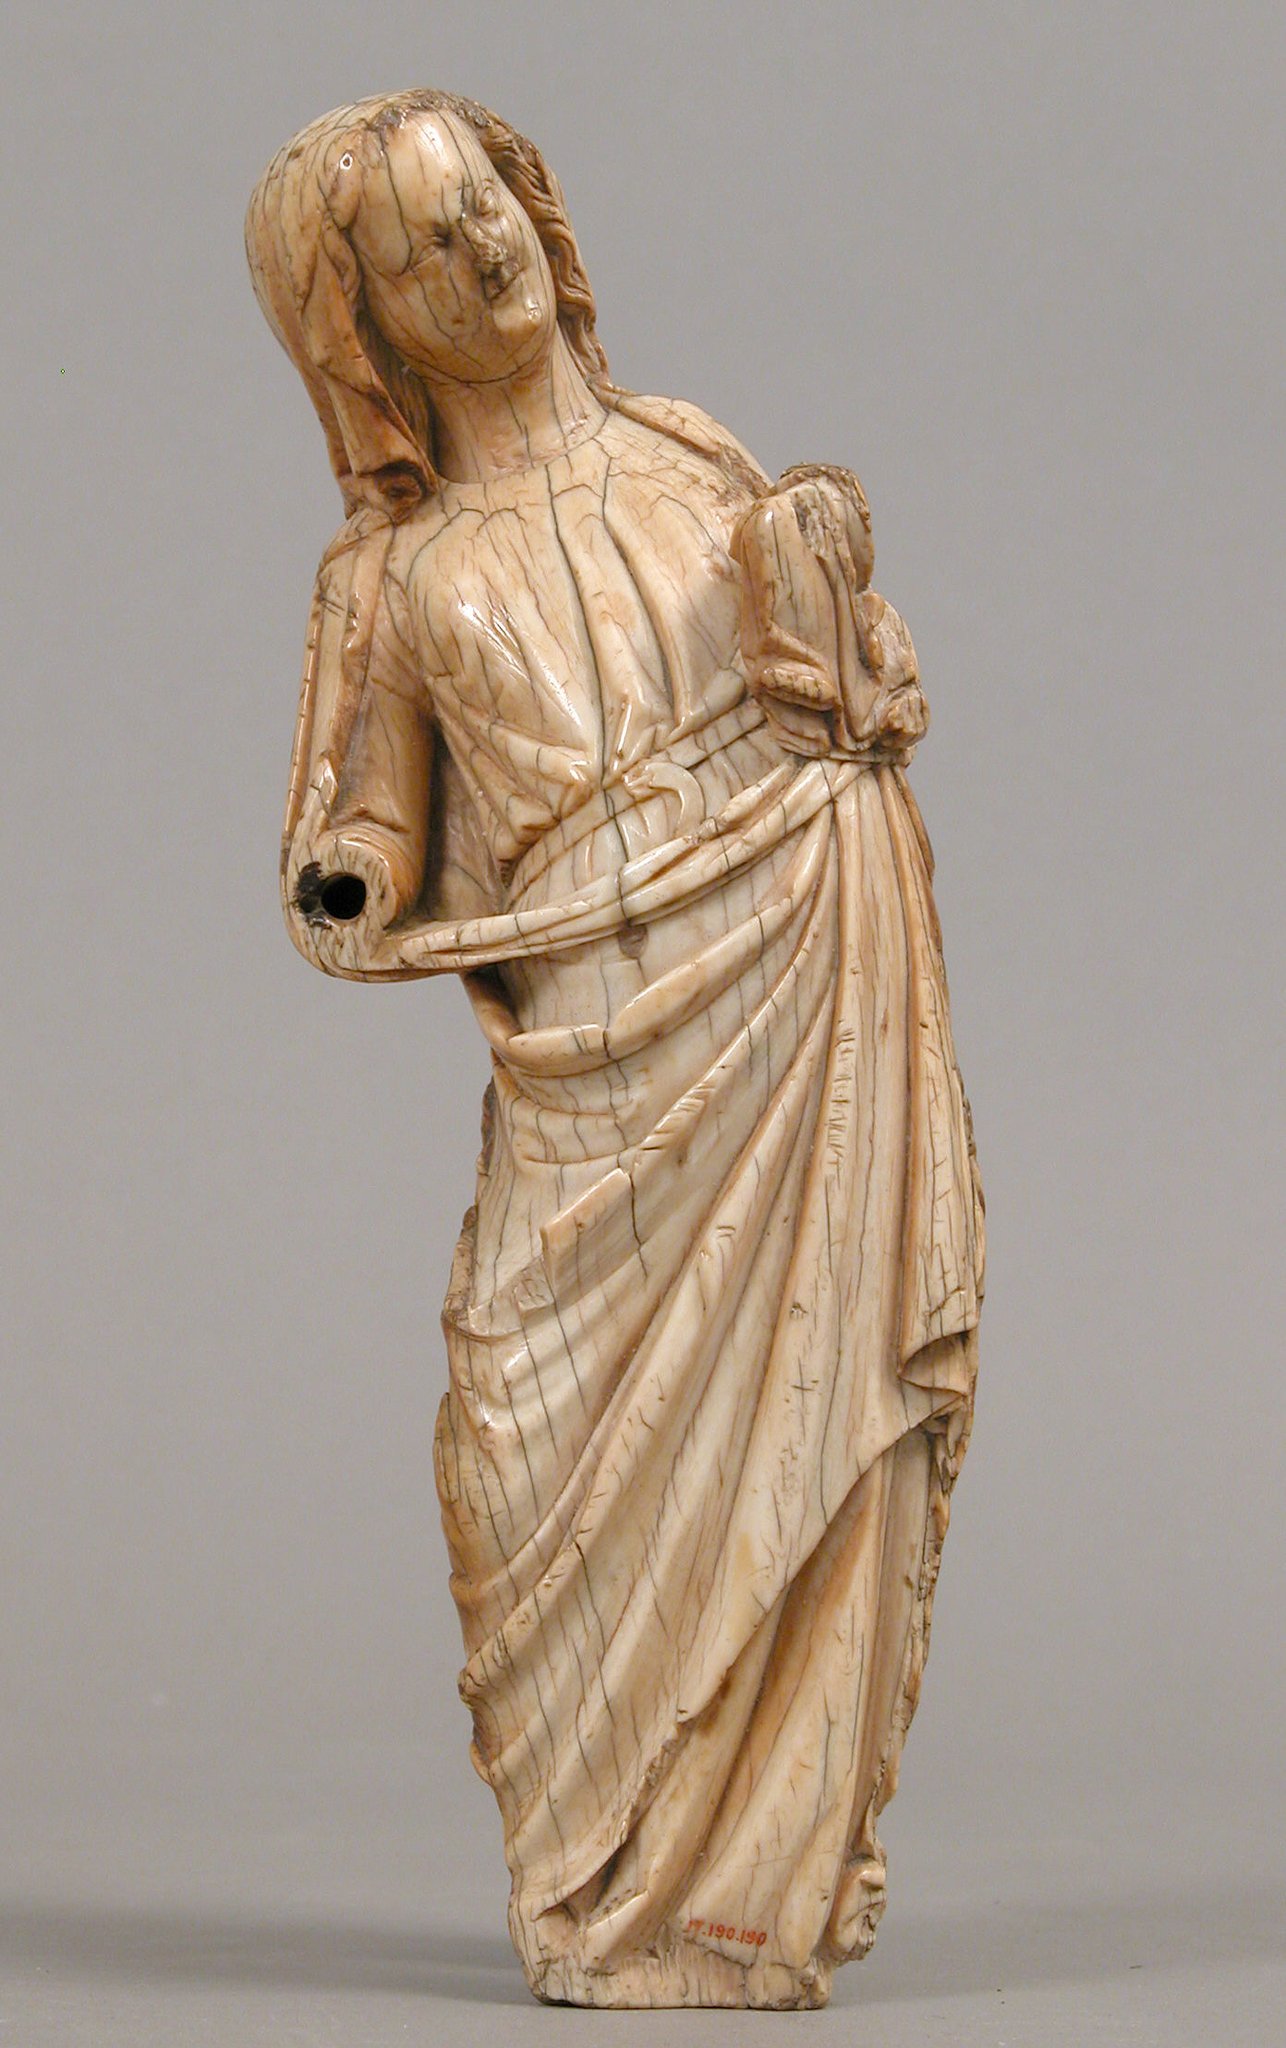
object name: statuette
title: Virgin and Child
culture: french, north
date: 1270-1280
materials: ivory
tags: madonna and child